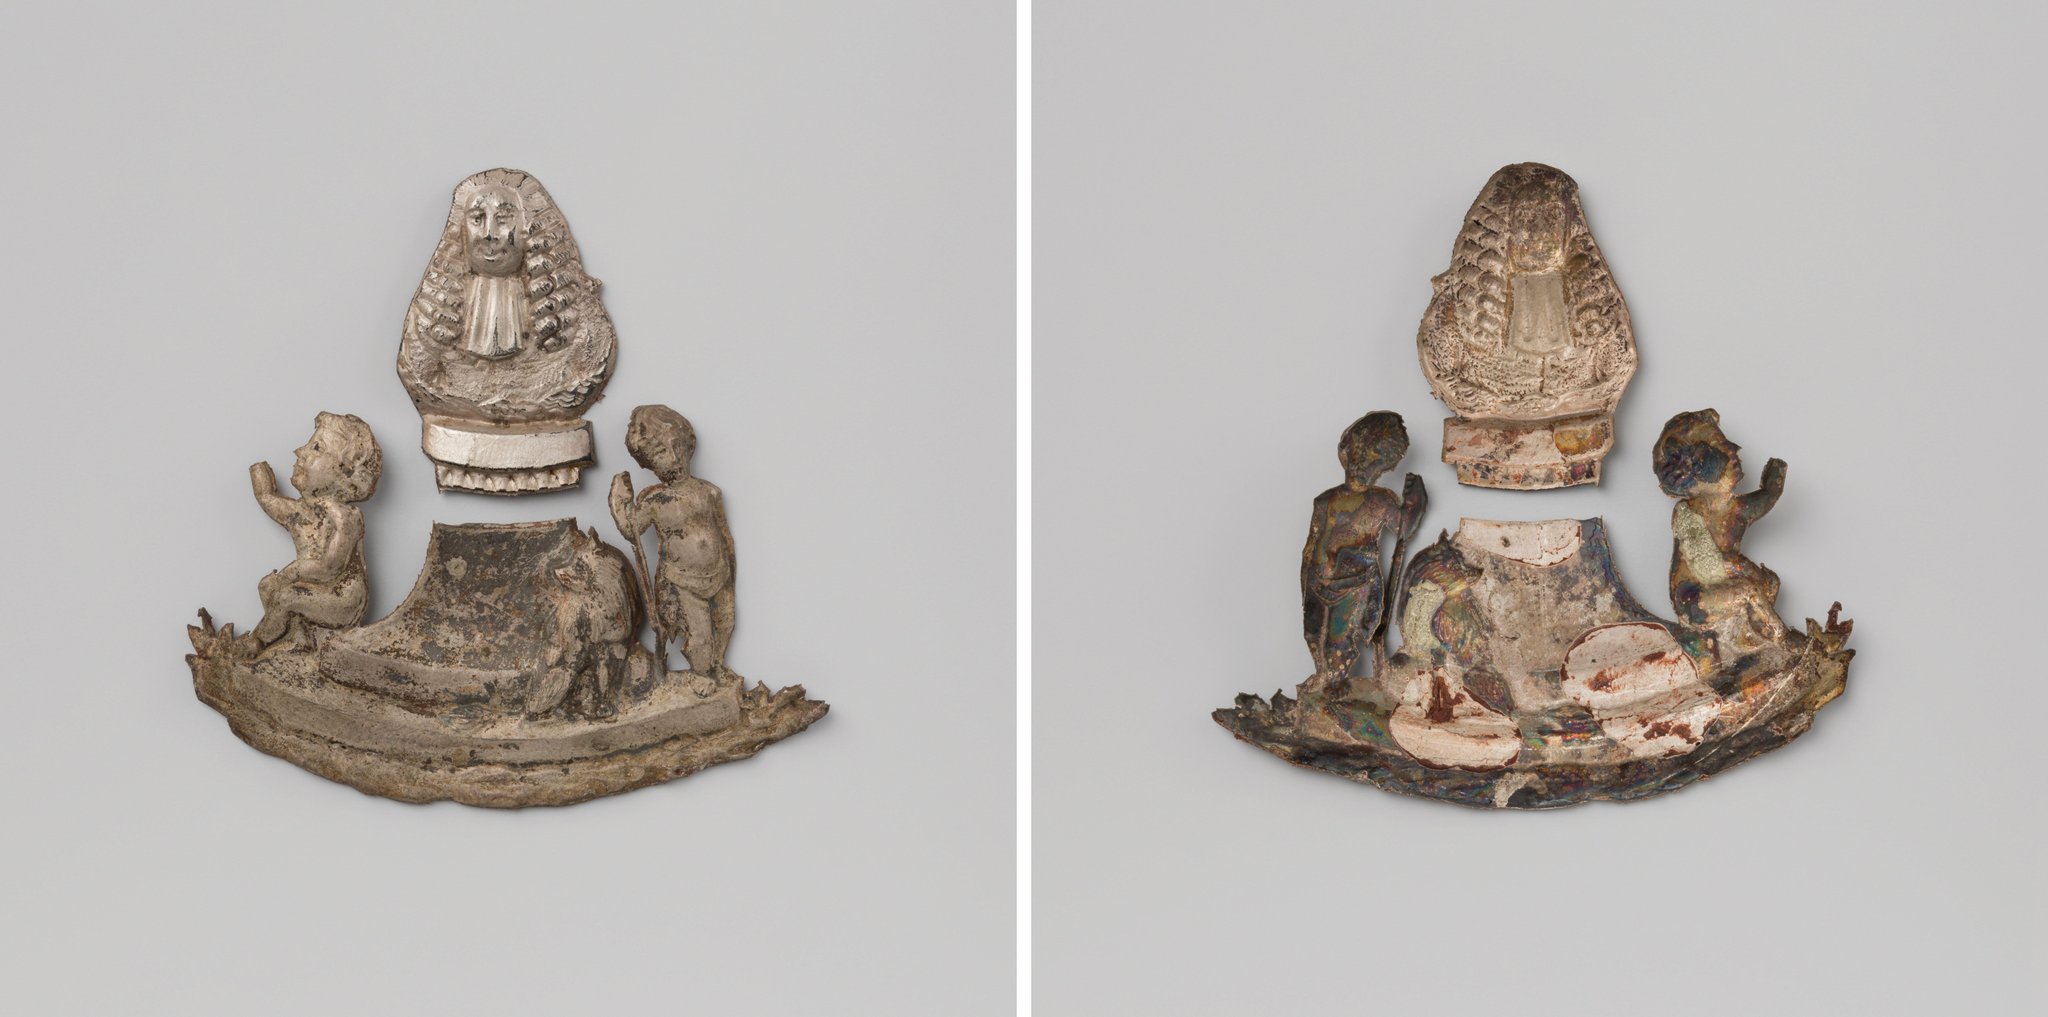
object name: plaque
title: Hendrik Danielsz Hooft, burgemeester van Amsterdam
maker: Anonymous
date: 1787-1794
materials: silver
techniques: repoussé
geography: netherlands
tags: amsterdam, mayor, hendrik danielsz. hooft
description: eenzijdige plaquette in laag relief. Voorzijde: buste man op sokkel met opschrift, geflankeerd door twee engeltjes, waarvan rechter vrijheidshoed op speer in hand heeft en linker op bazuin blaast; op voorgrond zittende, omkijkende hond. Keerzijde: blanco